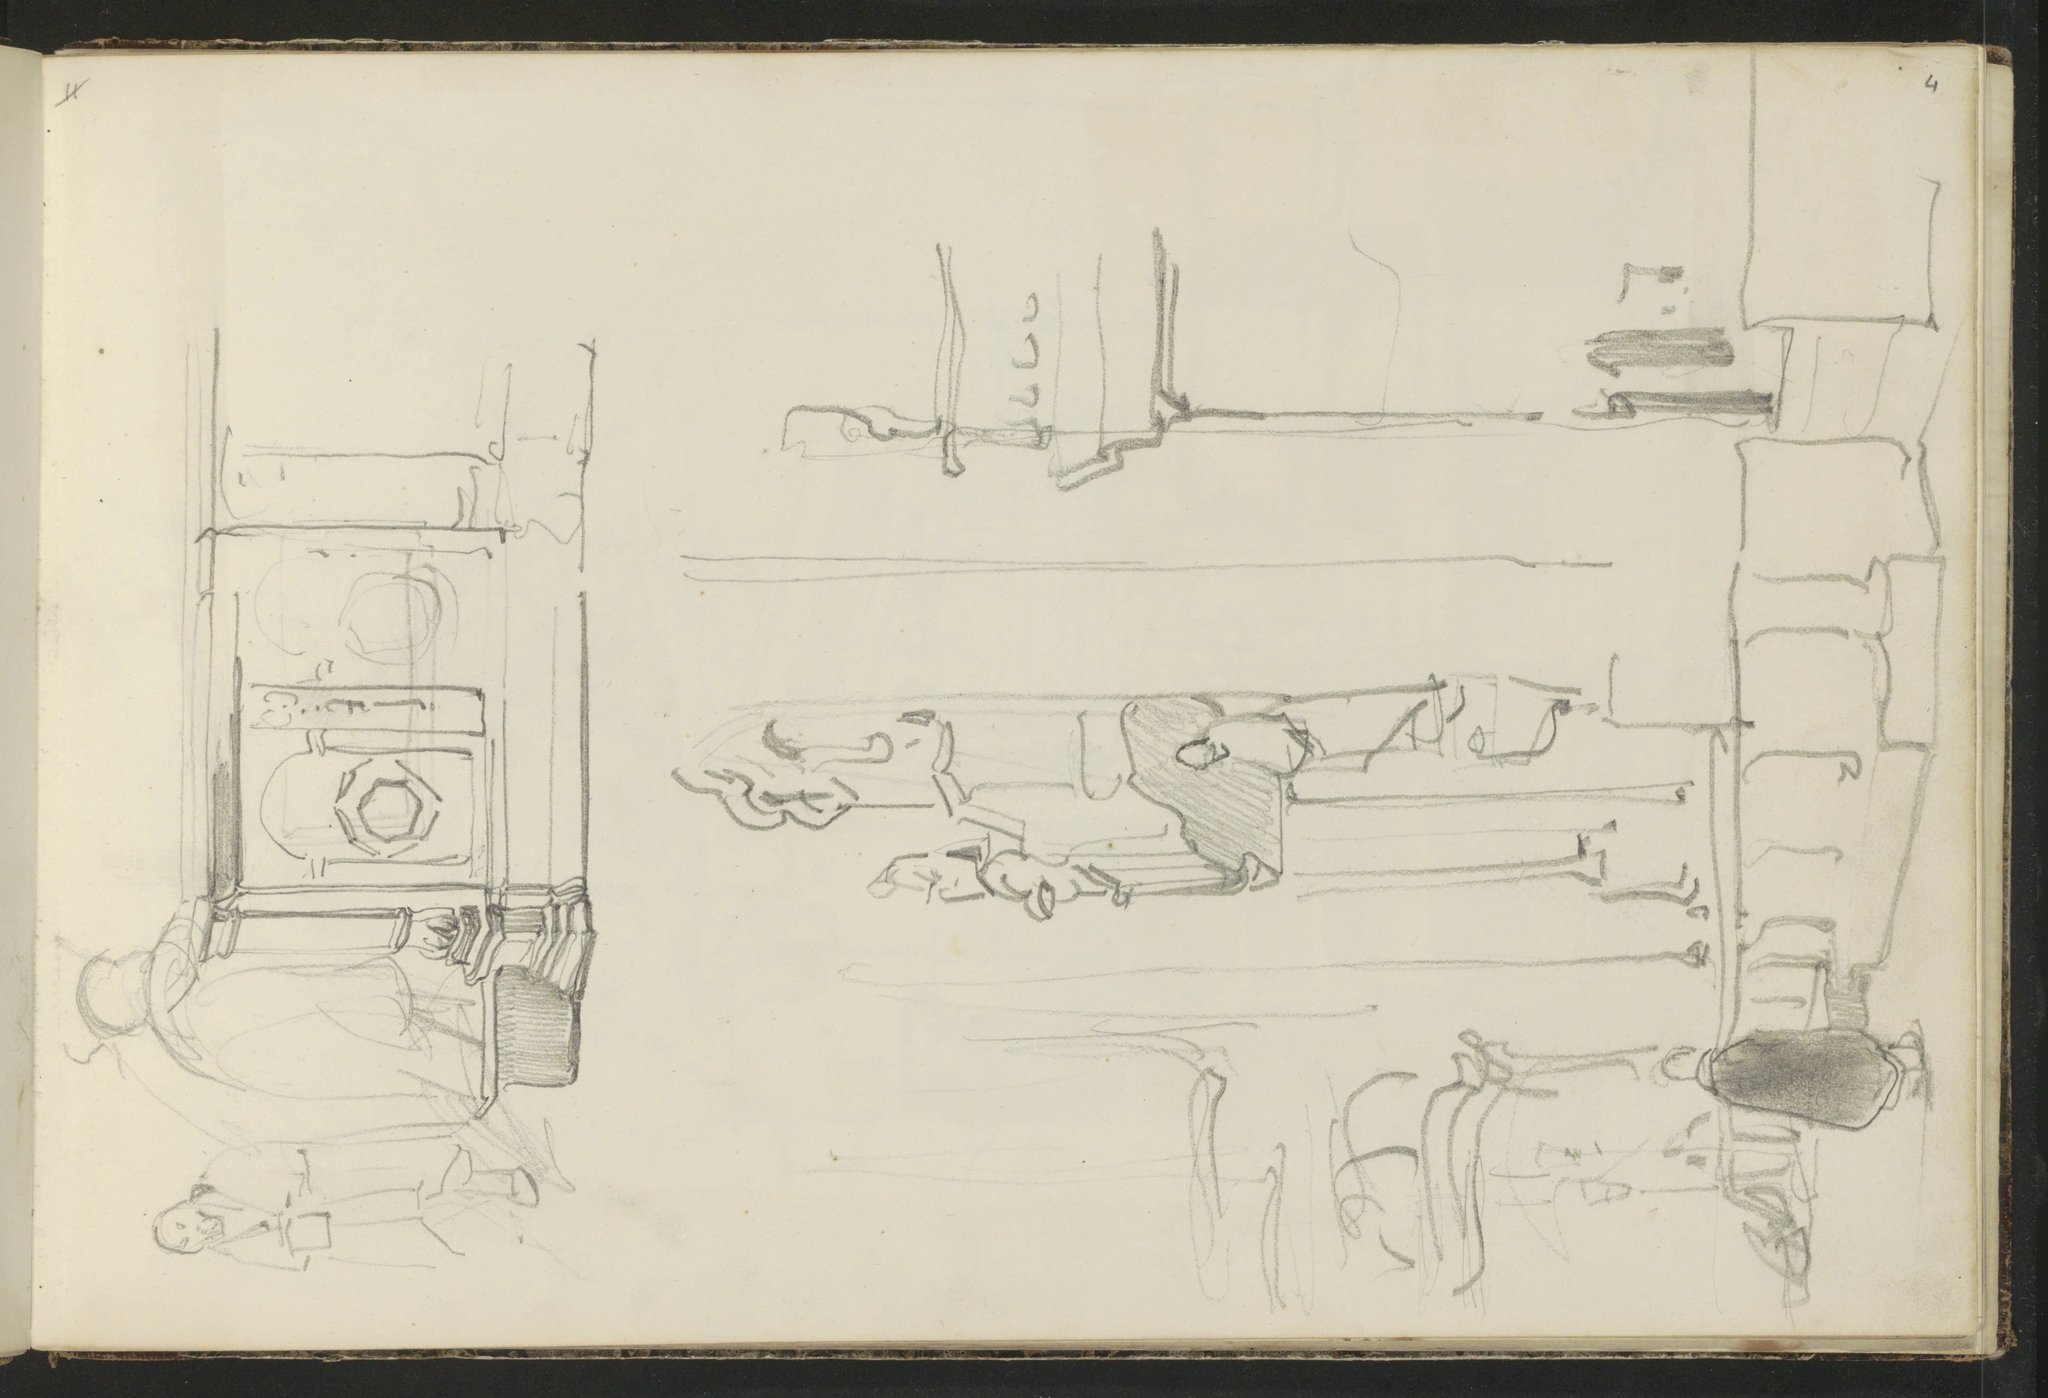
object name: sketchbook leaf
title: Figuur in een kerkinterieur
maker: johannes bosboom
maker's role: draughtsman, painter, print maker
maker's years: 1817-1891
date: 1827-1891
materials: paper, pencil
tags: interior of church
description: Blad 4 recto uit een schetsboek met 11 bladen.